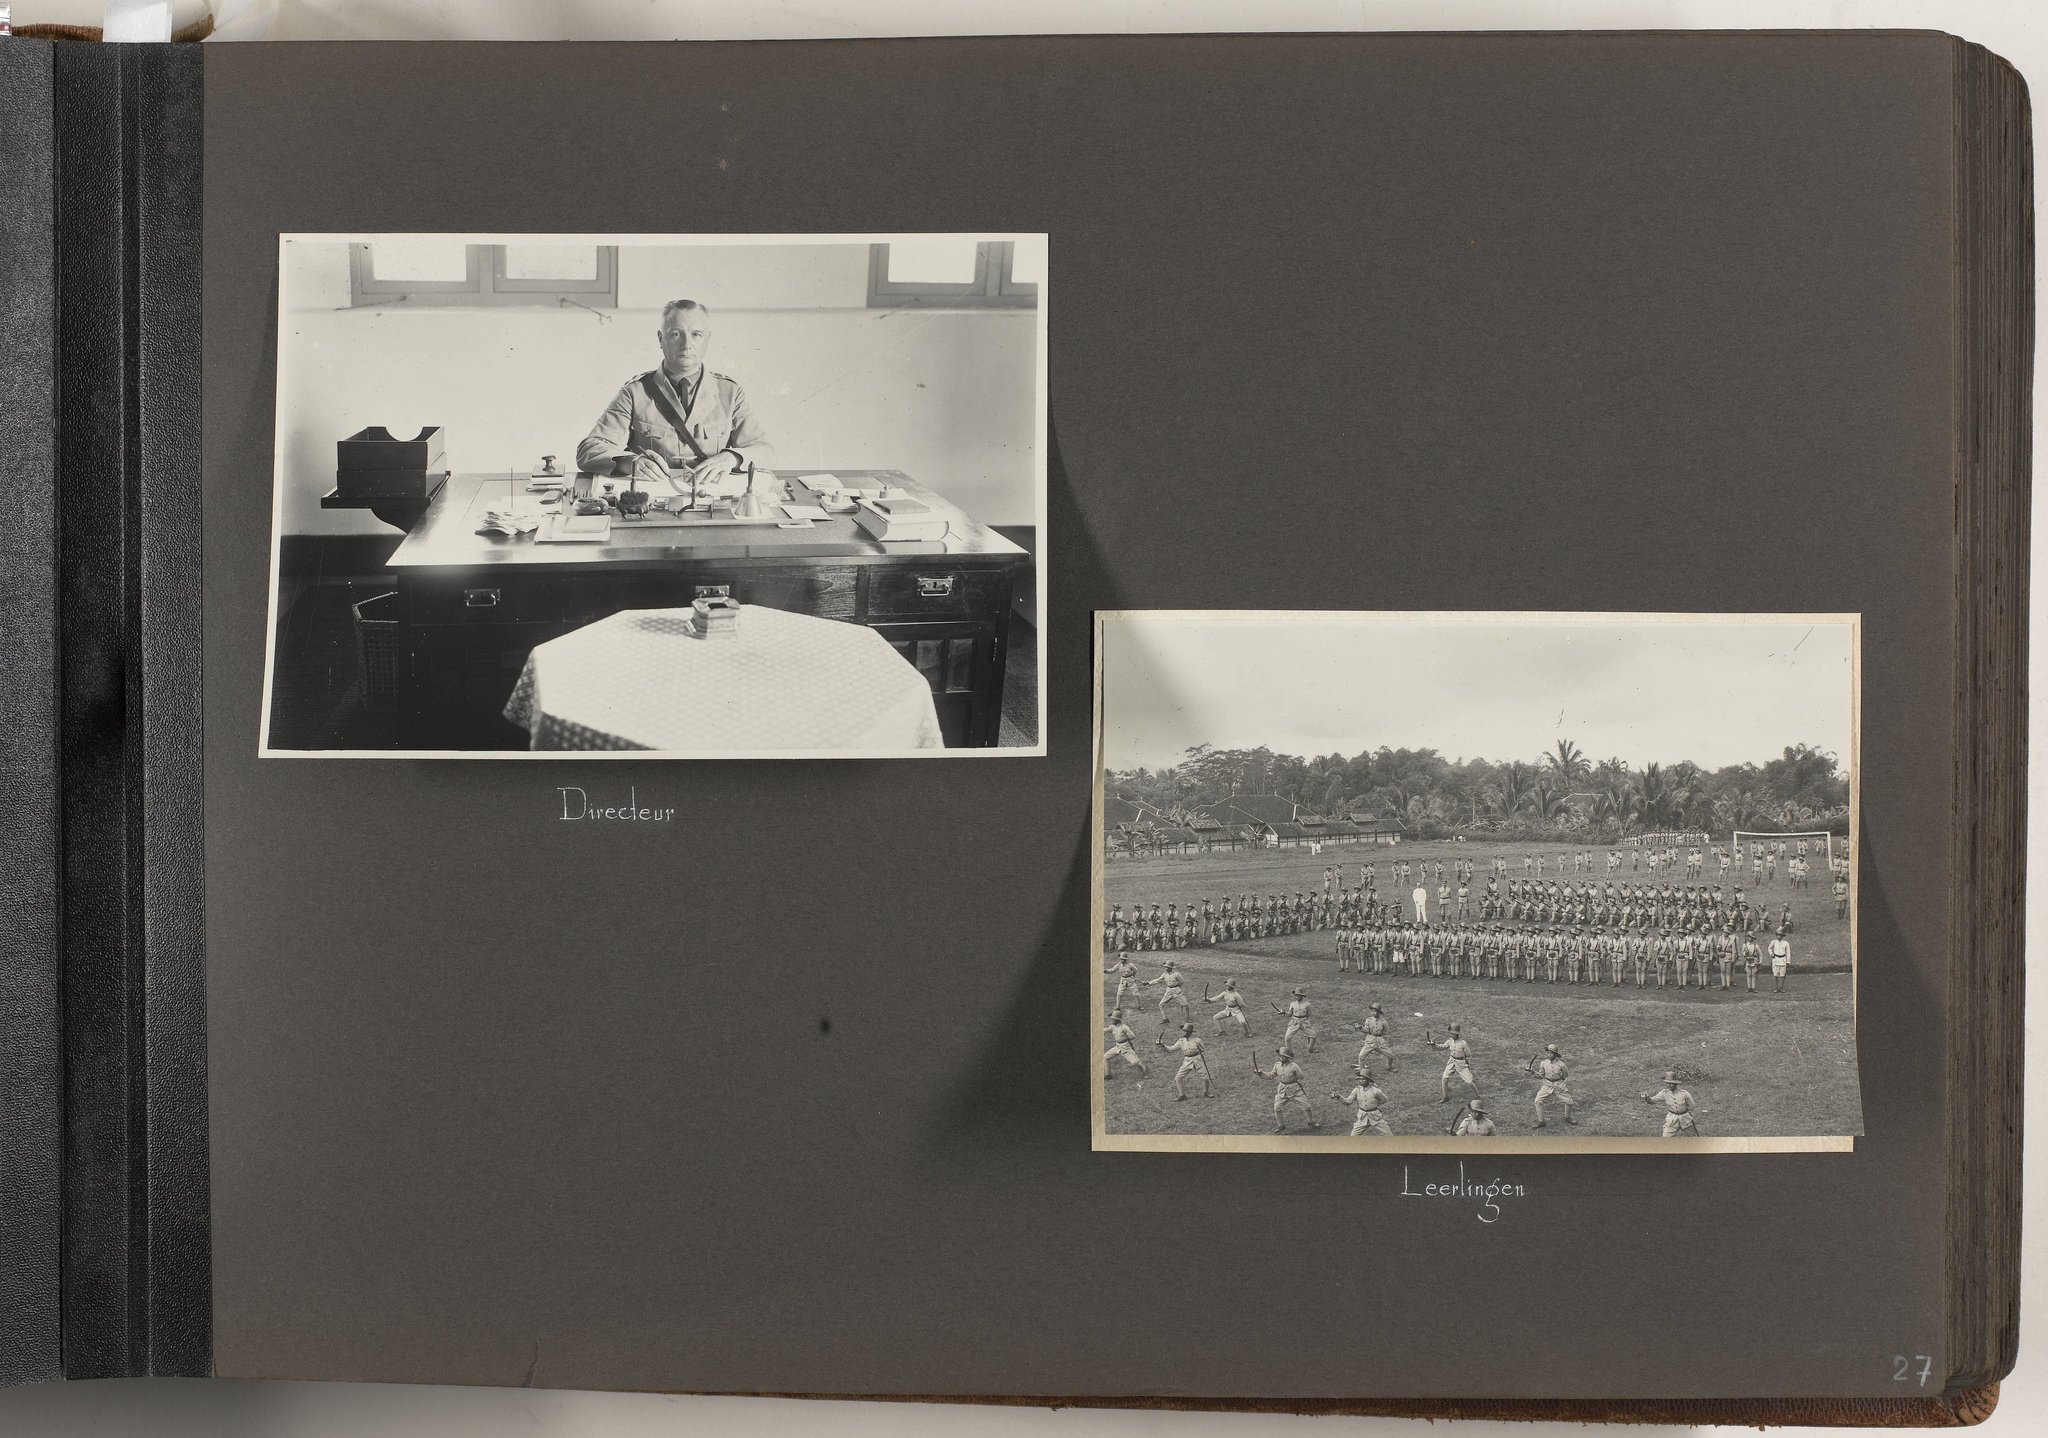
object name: photograph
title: Directeur / Leerlingen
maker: Anonymous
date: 1925-1931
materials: cardboard, photographic support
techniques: gelatin silver print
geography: soekaboemi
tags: dutch east indies, the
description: Albumblad met twee foto's: portret van de directeur achter bureau en leerlingen tijdens exercitie, politieschool te Soekaboemi. Onderdeel van het fotoalbum aangeboden aan S. Koster door de Vereeniging van Hoogere Politie Ambtenaren in Nederlandsch-Indië in 1931.